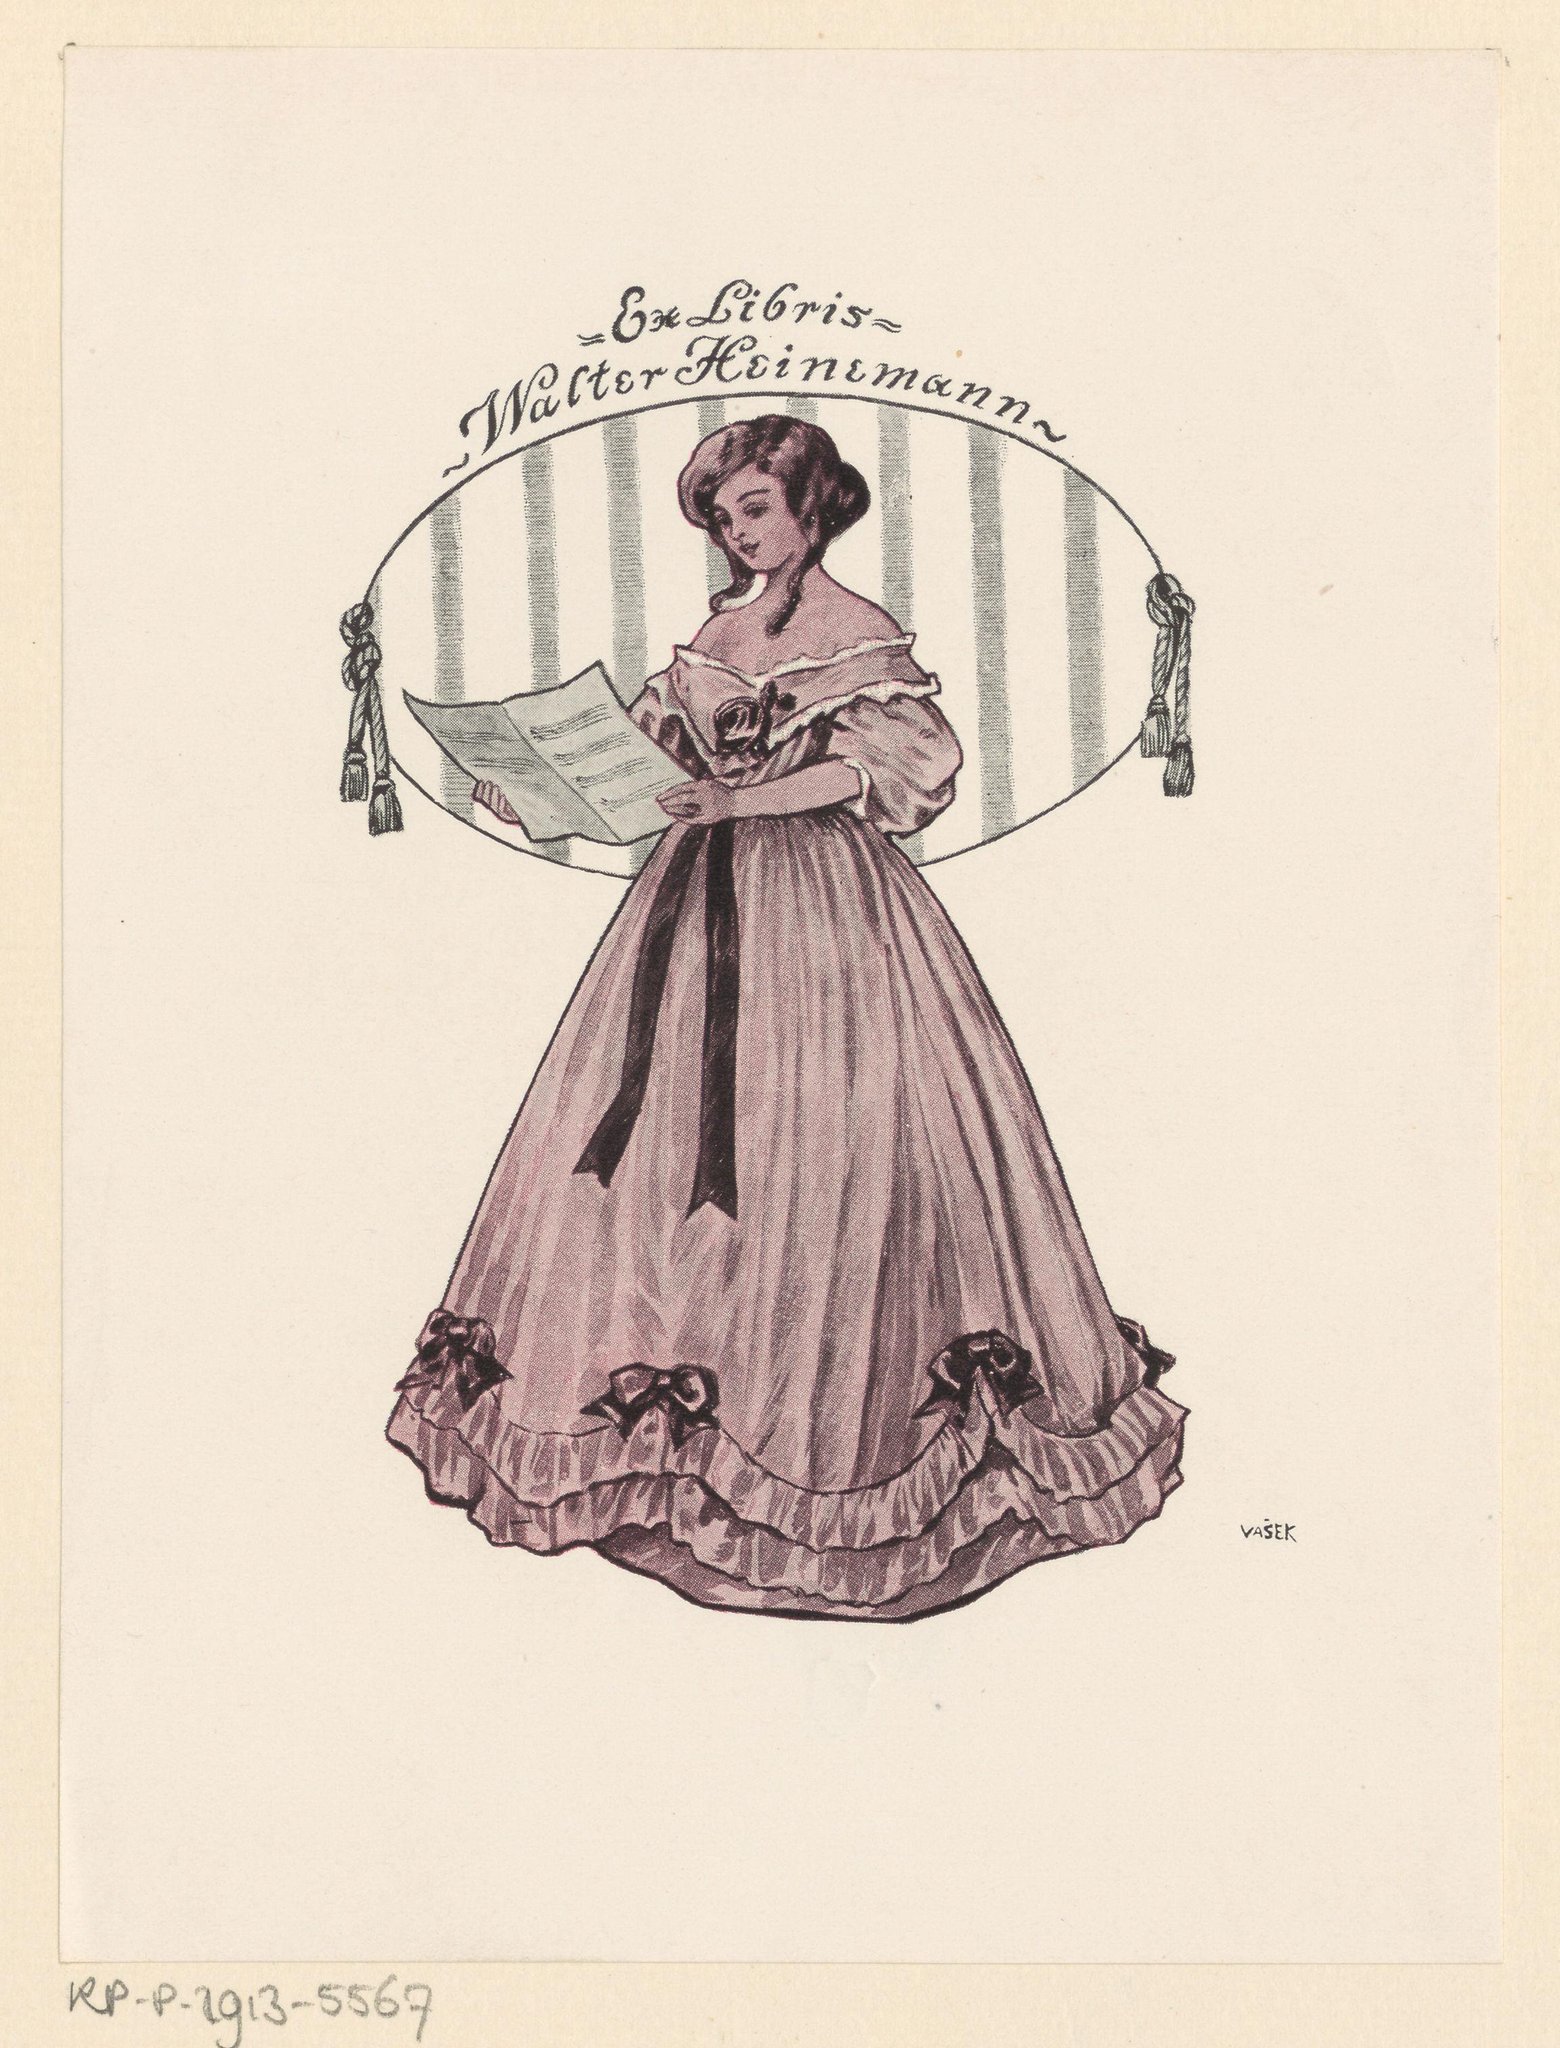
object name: bookplate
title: Ex libris van Walter Heinemann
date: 1900-1913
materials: paper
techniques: autotype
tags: notation of music, dress, gown: ball gown, standing figure - aa - female human figure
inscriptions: collector's mark: Lugt 2233, collector's mark: Lugt 2760